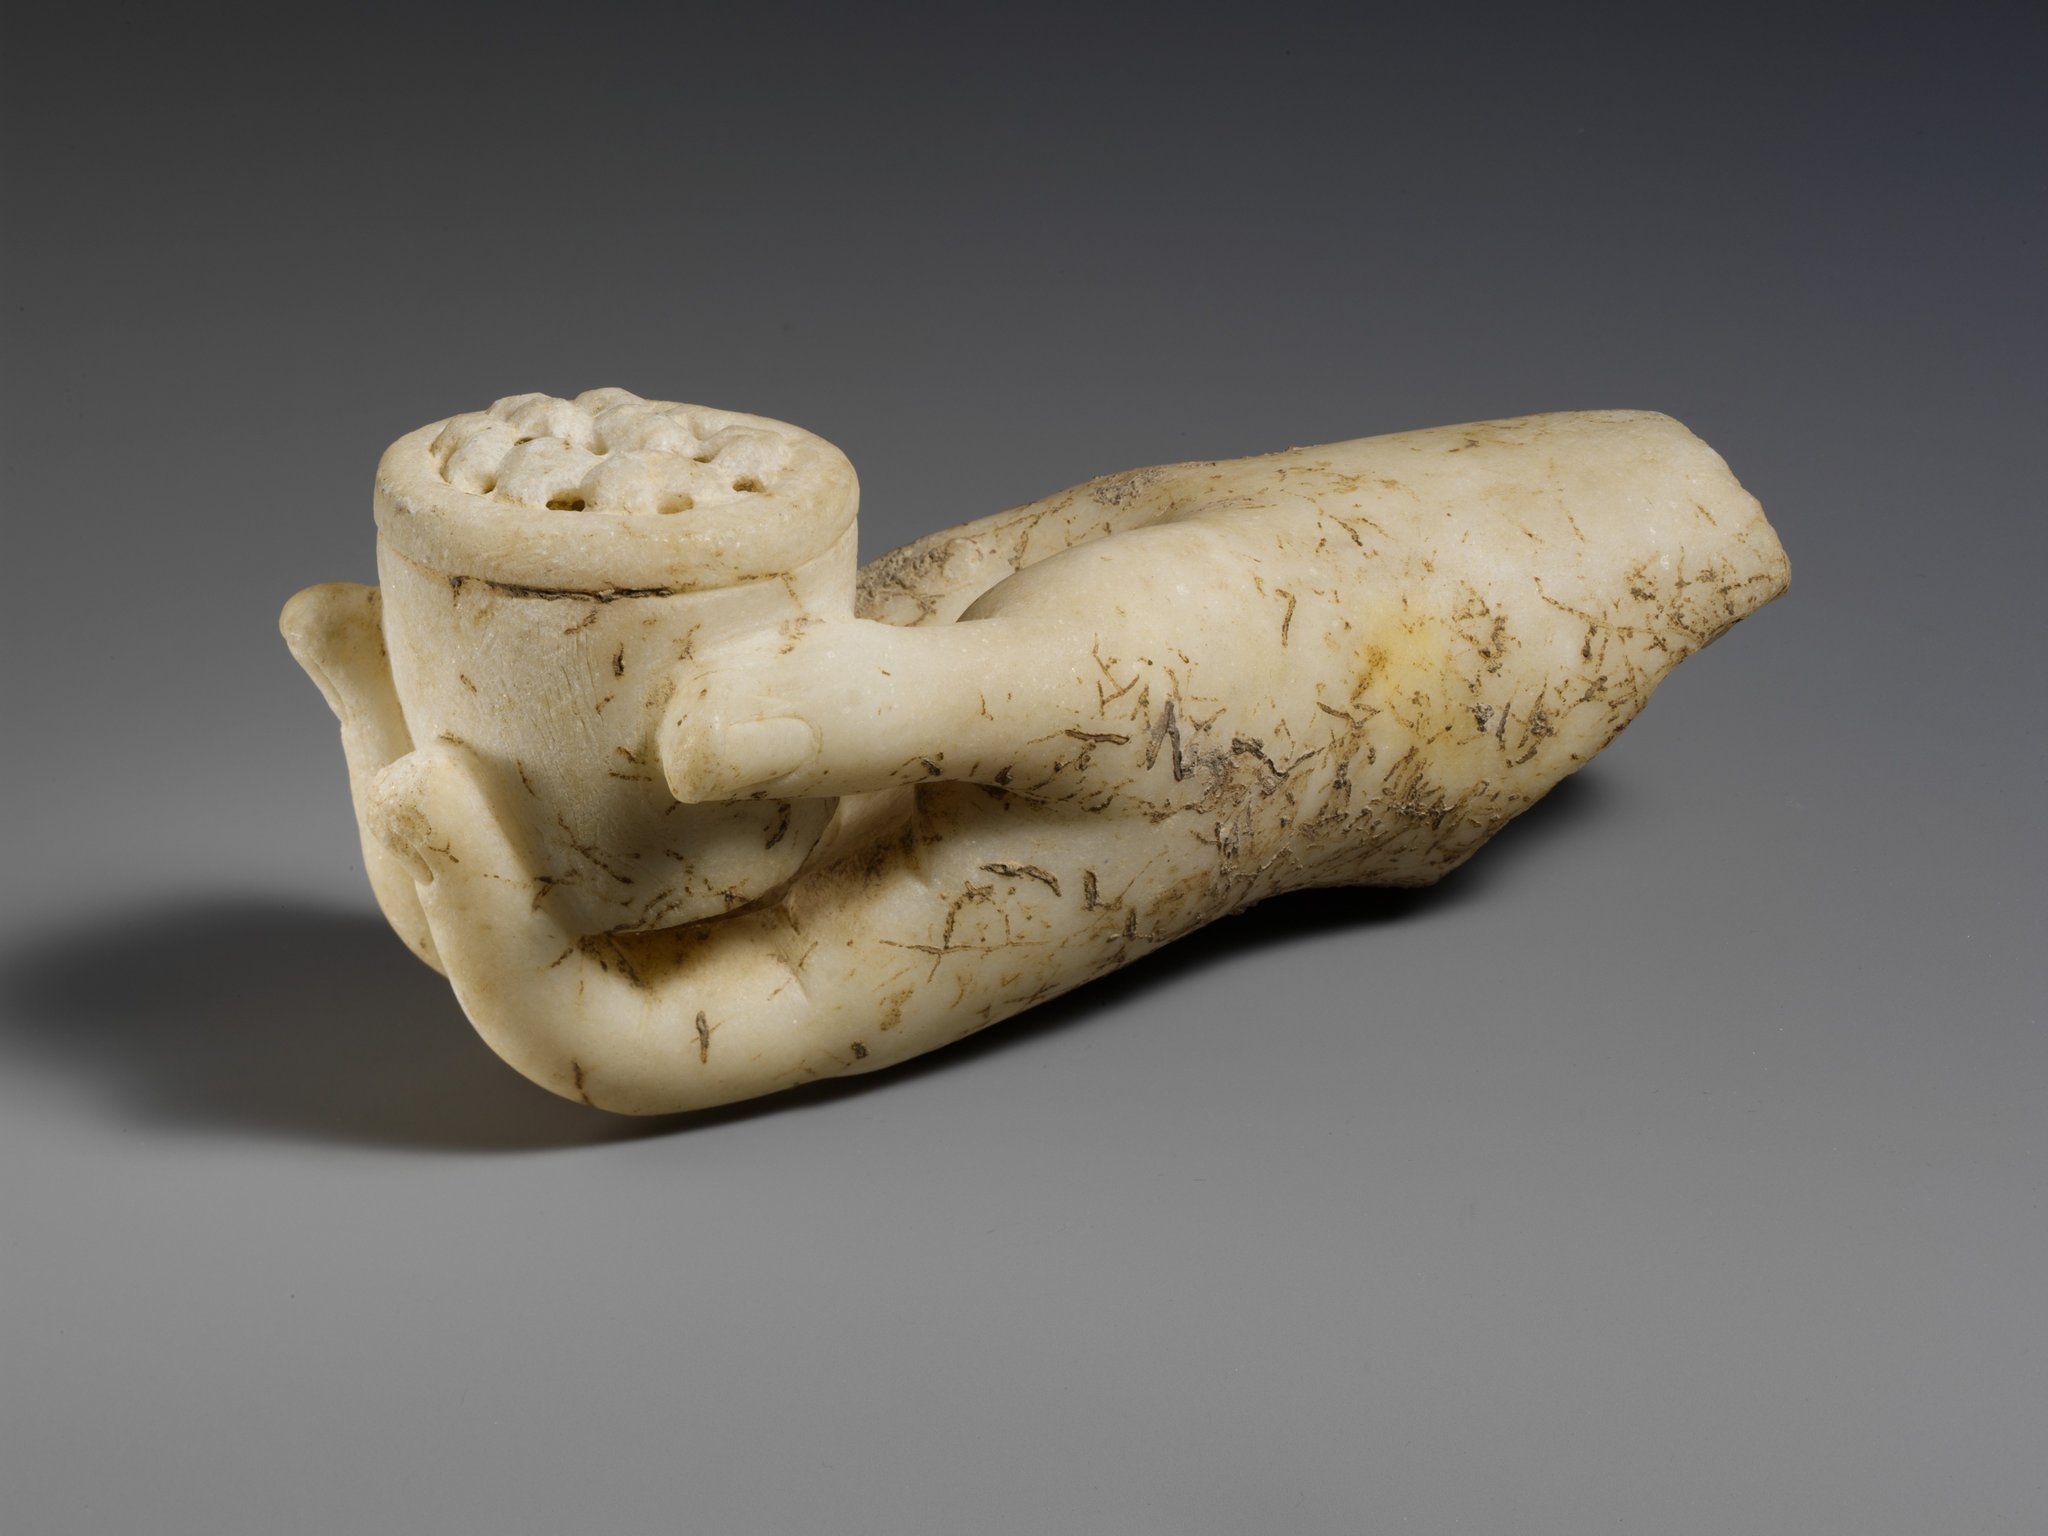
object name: hand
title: Marble left hand holding a small box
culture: roman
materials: marble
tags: hands